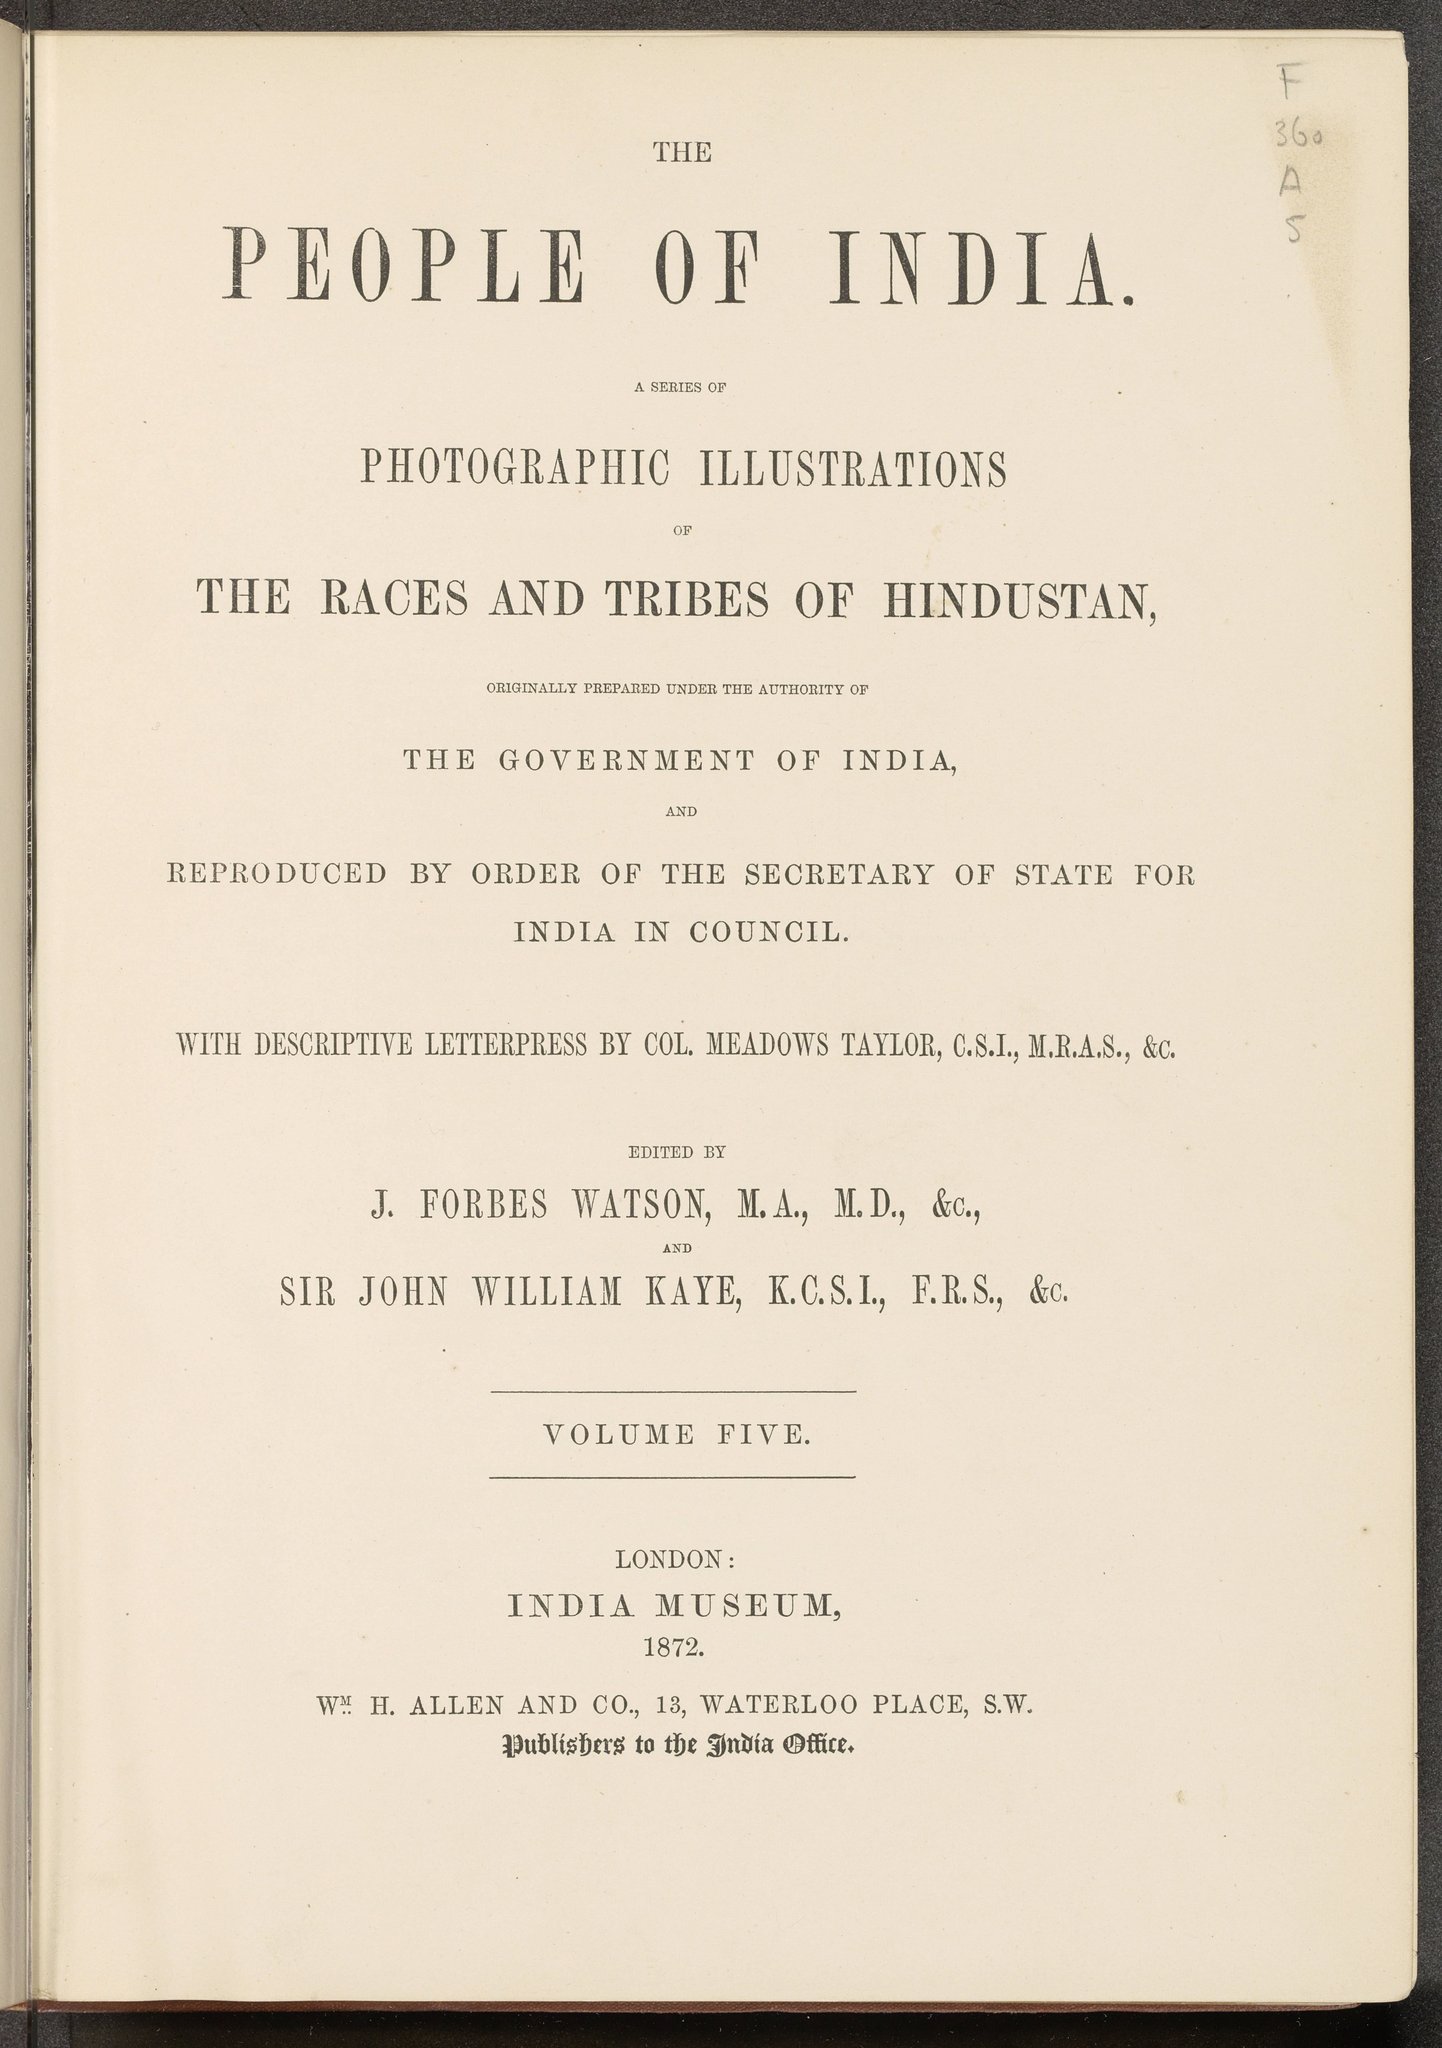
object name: book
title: The people of India : a series of photographic illustrations, with descriptive letterpress, of the races and tribes of Hindustan Volume five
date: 1872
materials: cardboard, linen, paper, photographic support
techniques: albumen print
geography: london